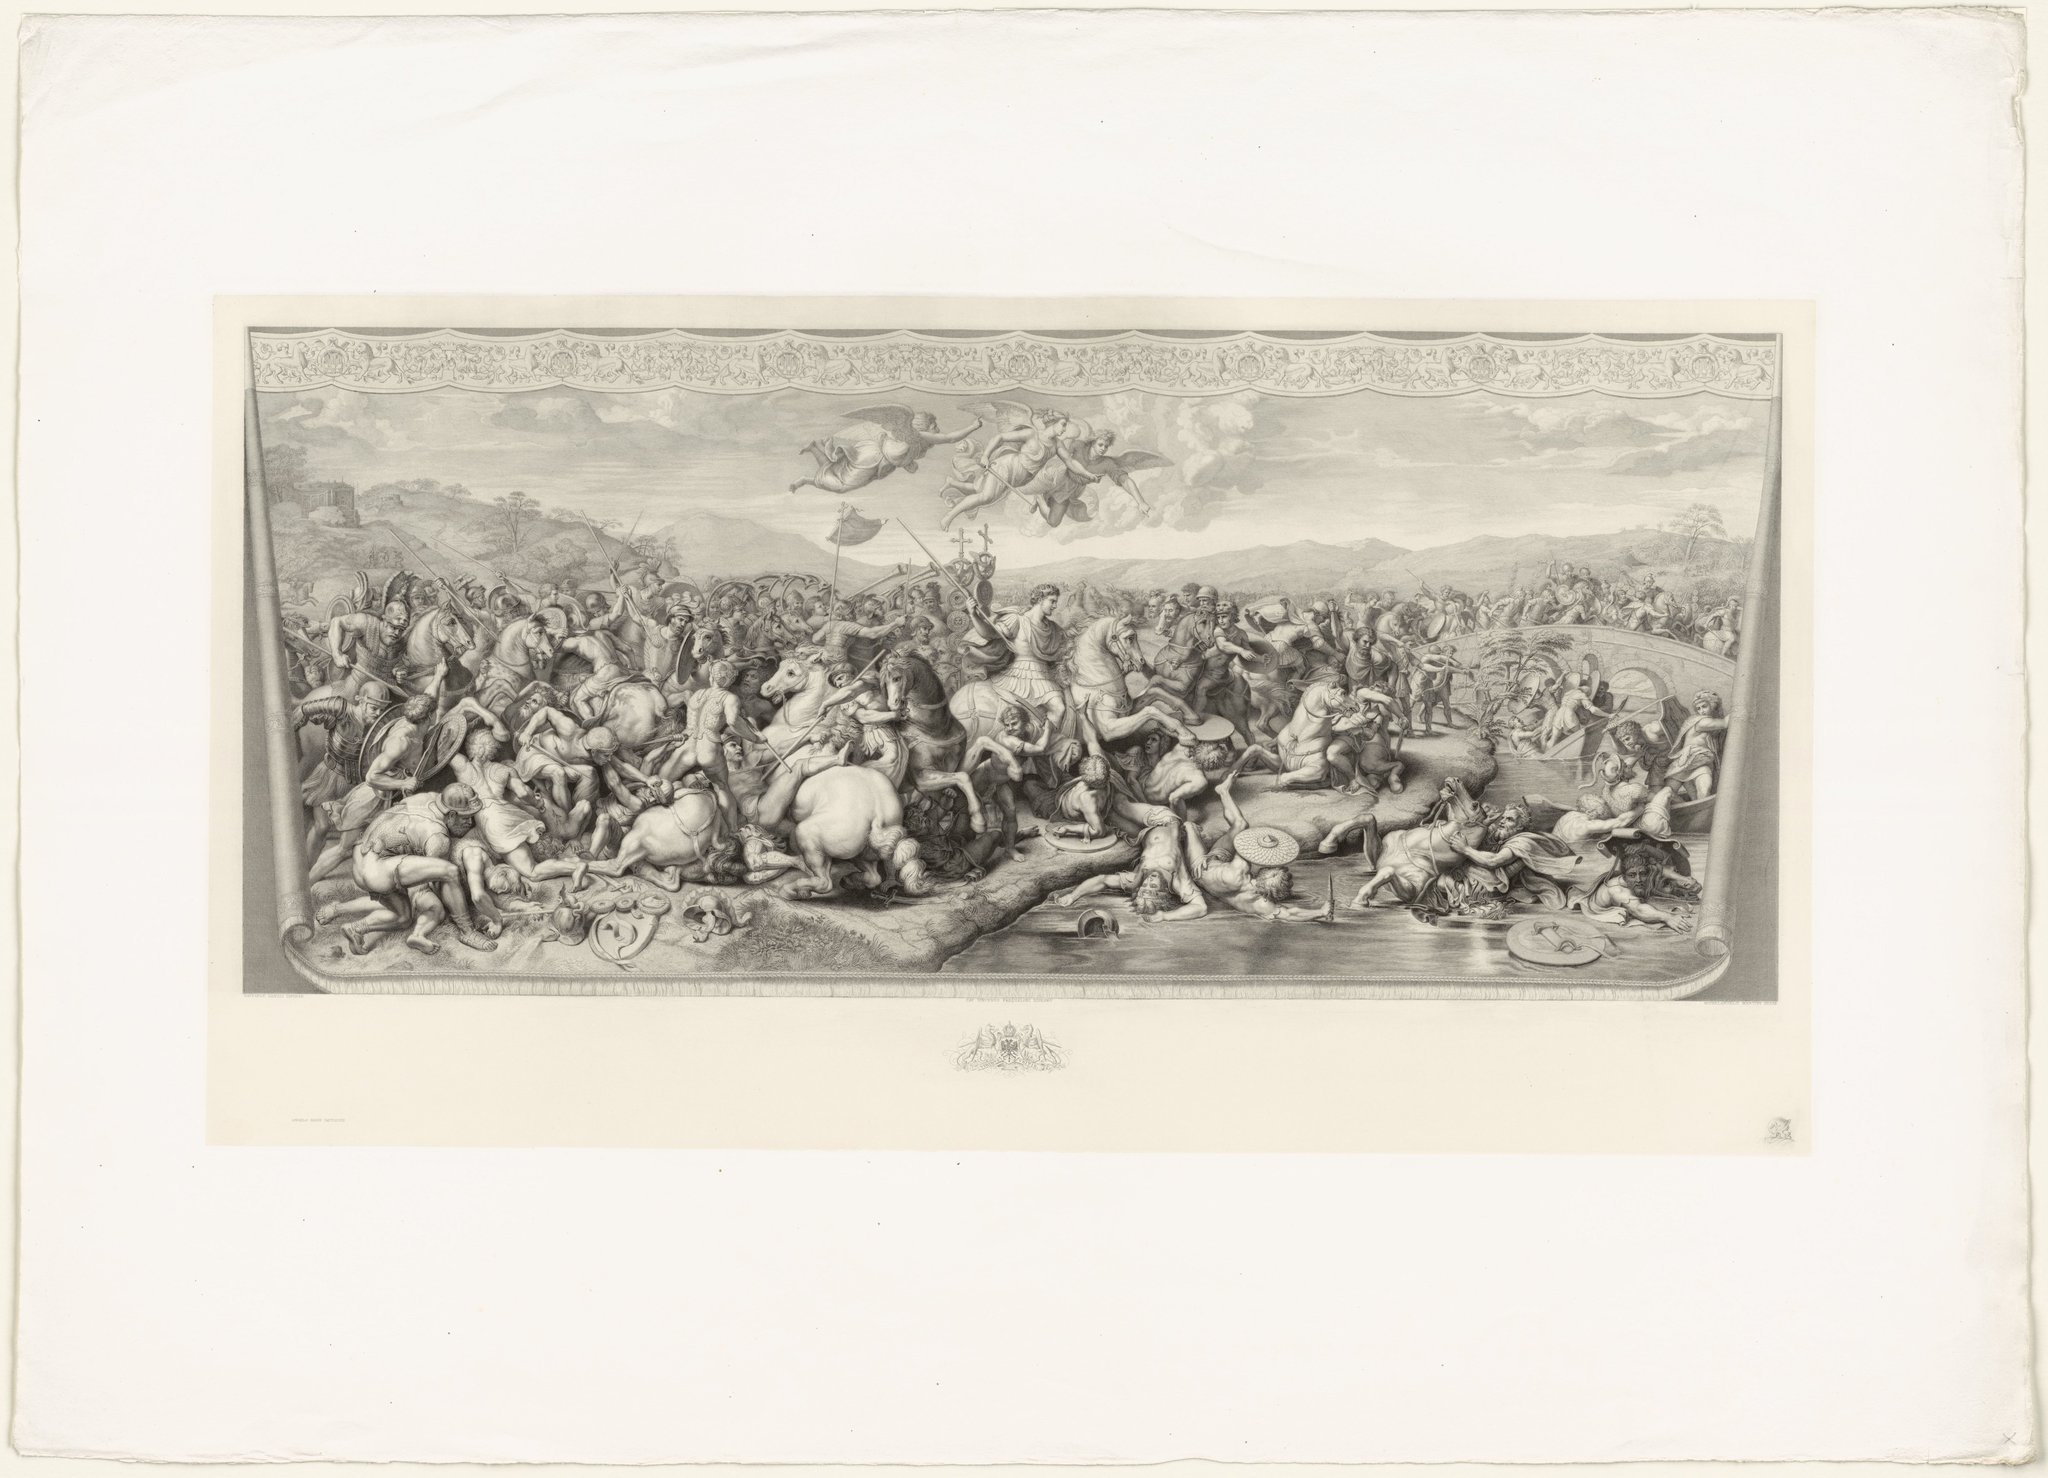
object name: print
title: Veldslag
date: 1816-1882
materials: paper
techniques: engraving, etching